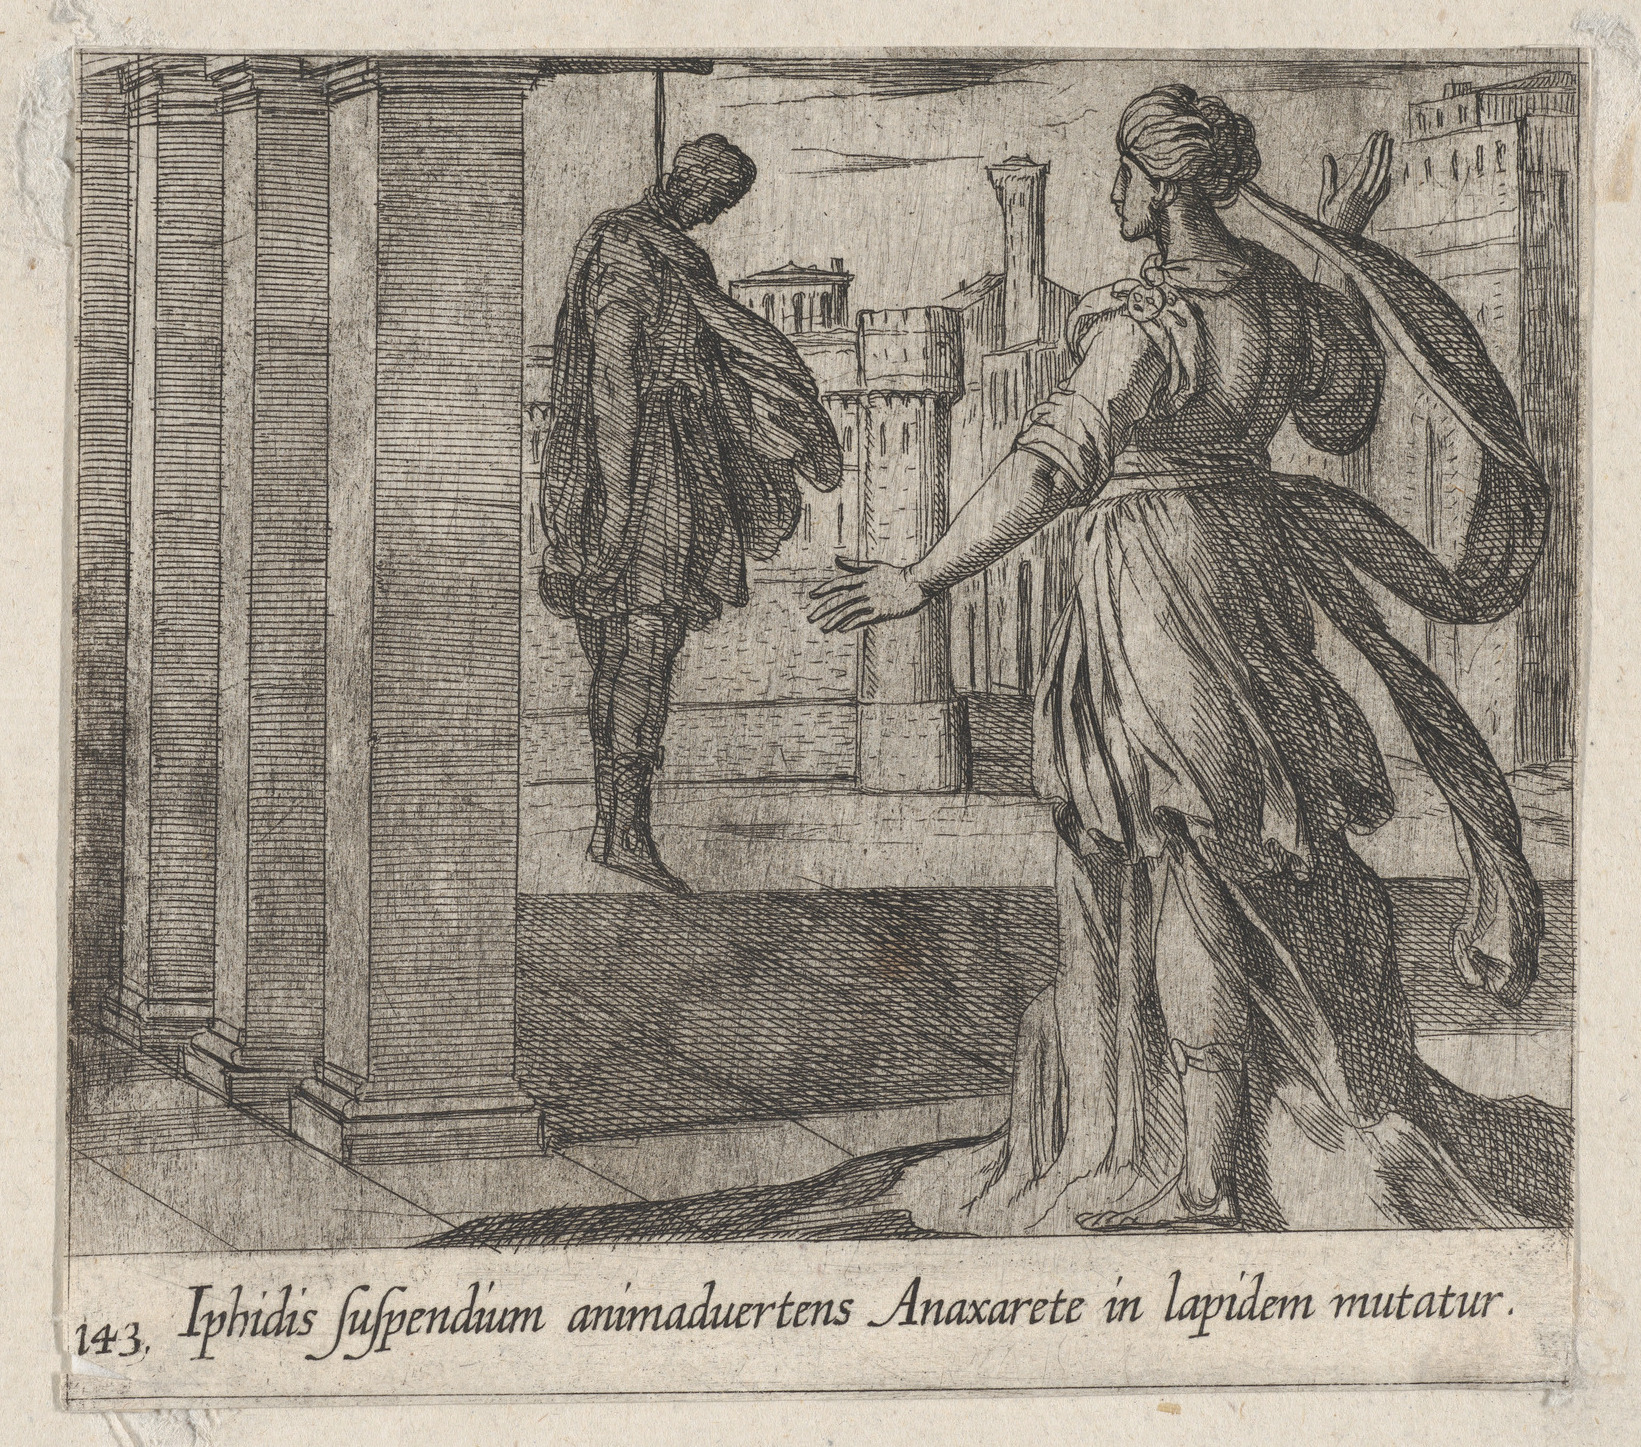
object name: print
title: Plate 143: Anaxarete Seeing the Dead Iphis (Iphidis suspendium animaduertens Anaxarete in lapidem mutatur), from Ovid's 'Metamorphoses'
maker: antonio tempesta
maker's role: artist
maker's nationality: italian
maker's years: 1555-1630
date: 1606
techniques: etching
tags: men,women,death